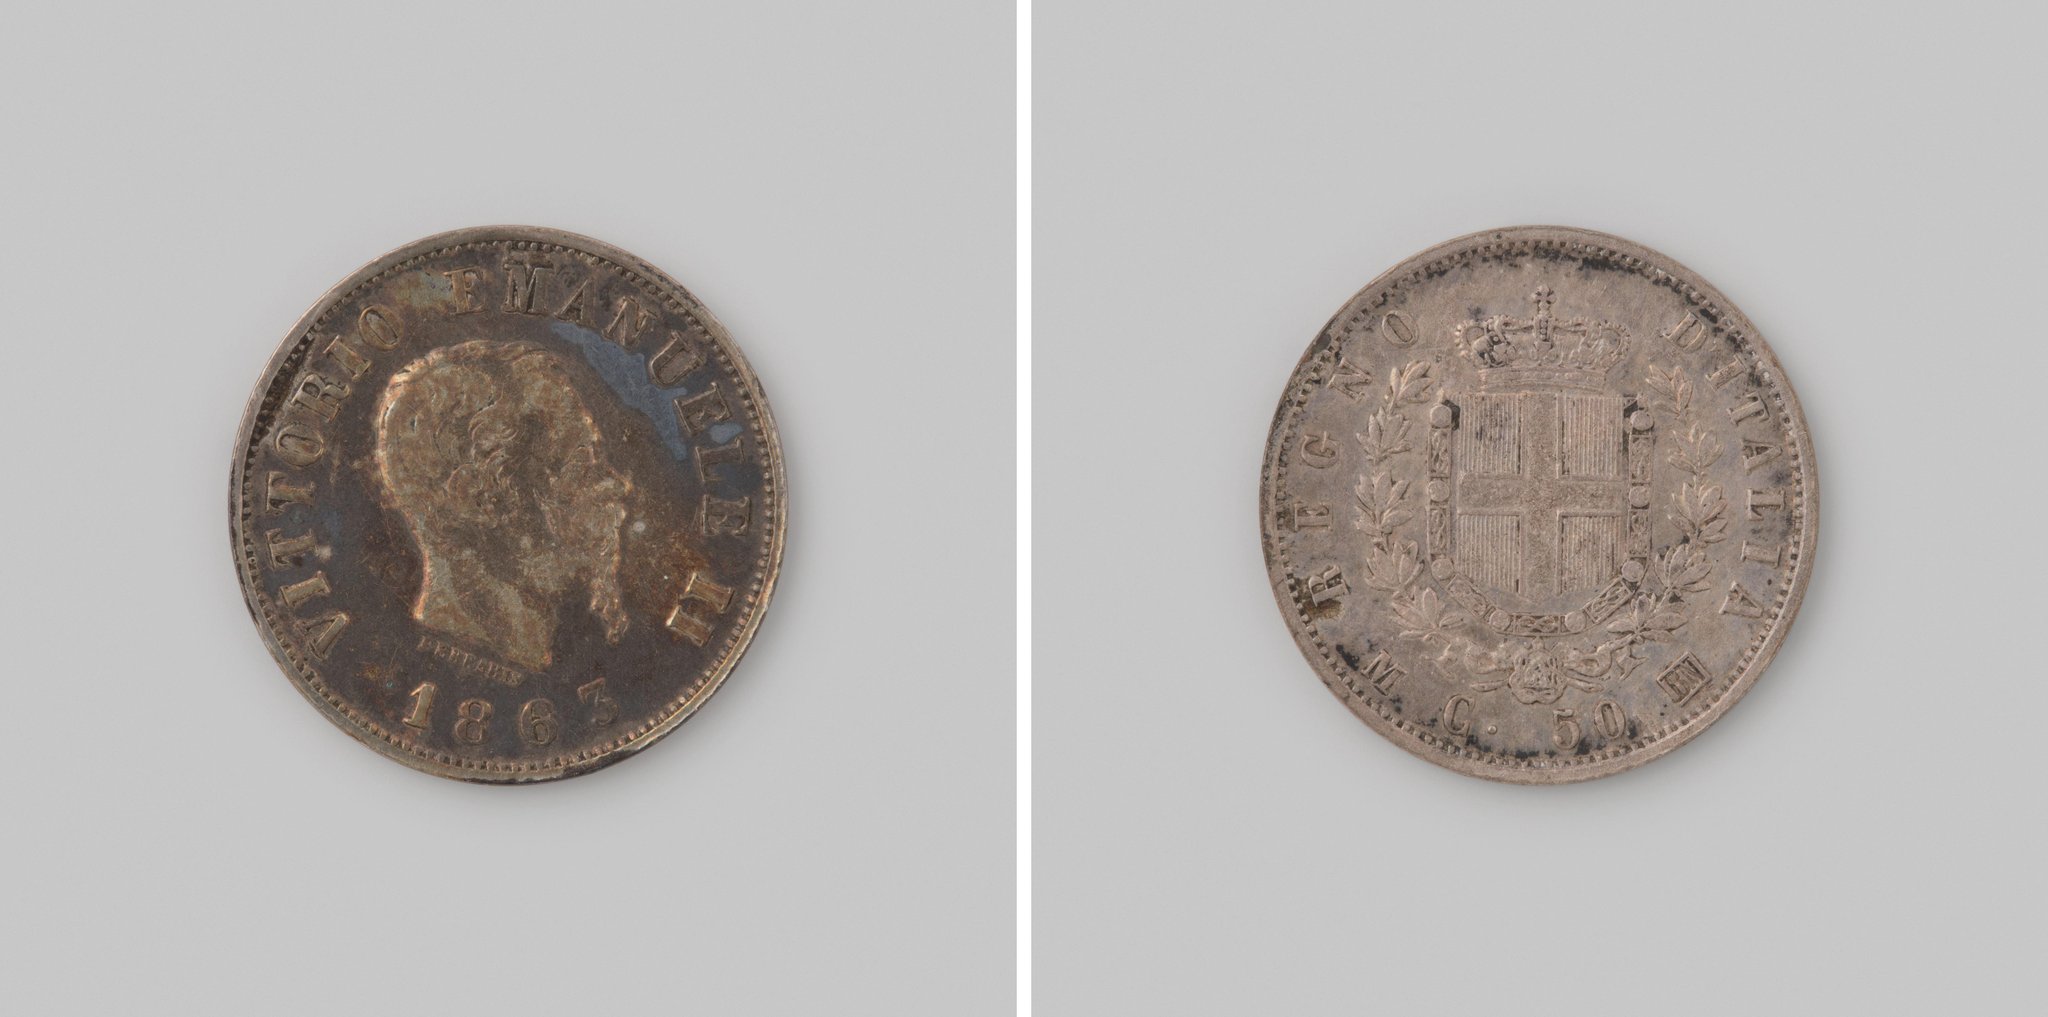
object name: coin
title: Italië, koning Vittorio Emanuele II, 50 centesimi, 1863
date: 1863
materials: silver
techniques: striking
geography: milan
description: Zilveren munt. Voorzijde: hoofd van de koning naar rechts. Daaronder jaartal. Keerzijde: binnen twee takken door keten van ridderorde met juweel omhangen gekroond wapenschild. Waarde-aanduiding: C. 50 onderaan. Links daarvan muntteken: letter M [=Milaan]. Gladde rand.